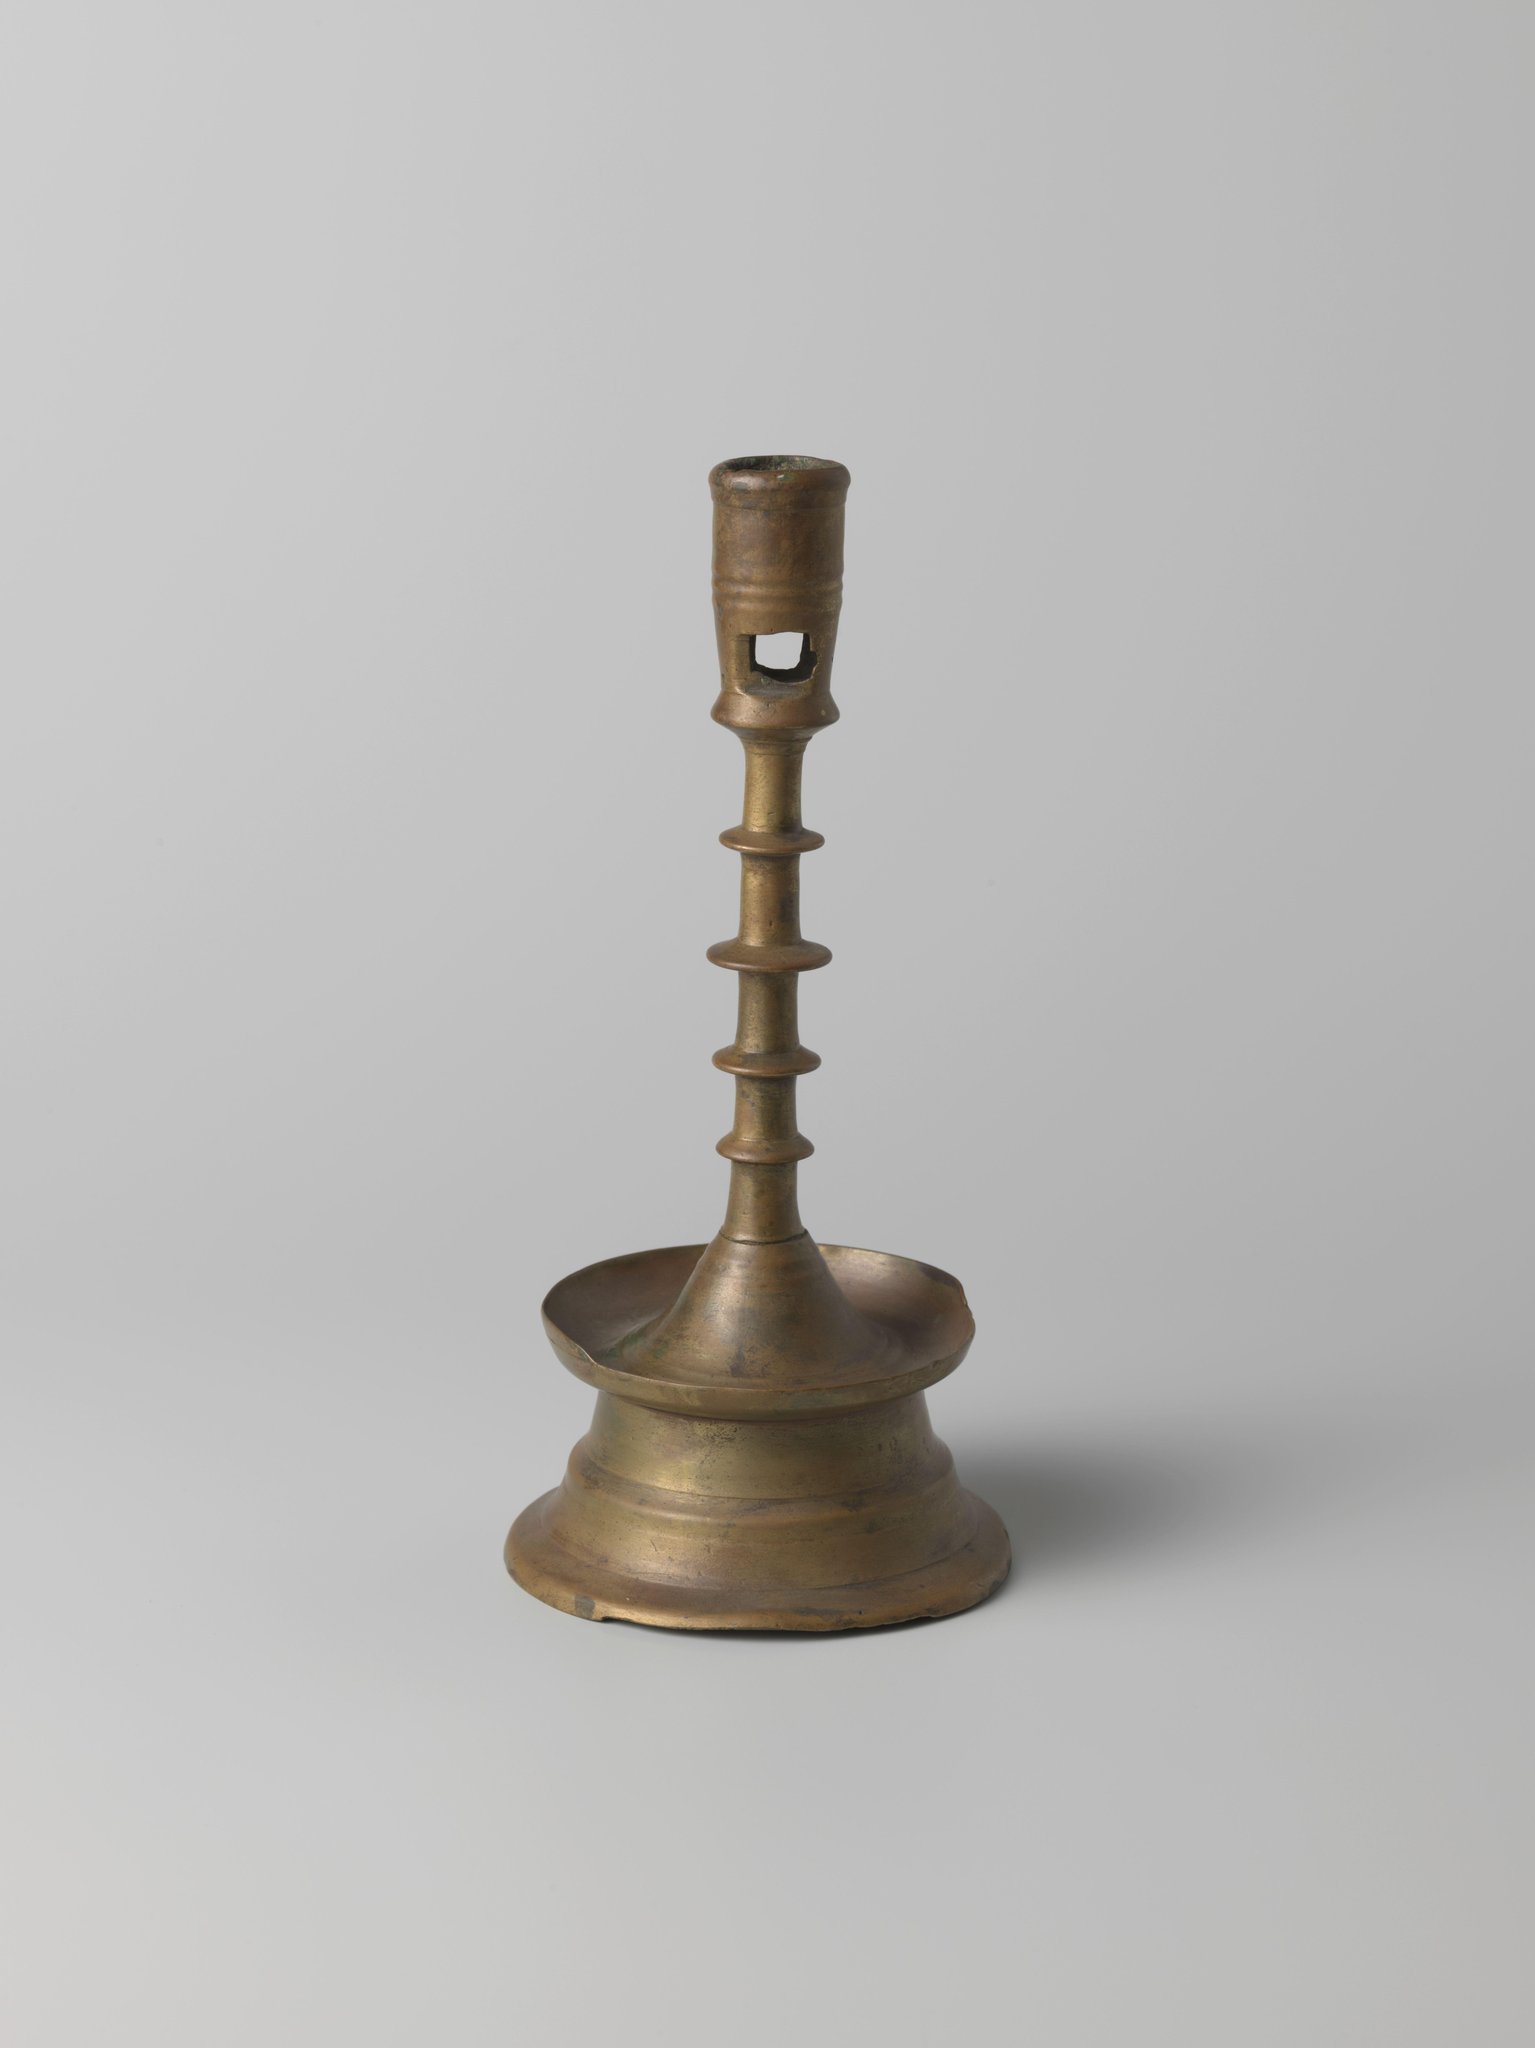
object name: candlestick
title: Kandelaar van messing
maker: Anonymous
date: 1450-1500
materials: brass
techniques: casting, riveted, turning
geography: northern netherlands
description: Het voorwerp is samengesteld uit twee delen: de voet en de stam met kaarsenhouder. Zij zijn gegoten en daarna afgedraaid. De hoge geprofileerde konische voet is bovenaan voorzien van een opstaande rand, waardoor hij tevens als vetvanger dienst kan doen. Op het kegelvormige middendeel is de stam geklonken en vervolgens aan de onderkant afgedraaid. De stam, die met vier knopen is versierd en waarvan één iets groter is, gaat bovenaan over in een geprofileerde cylindervormige houder met twee rechthoekige openingen. Voet en houder zijn met rillen versierd.